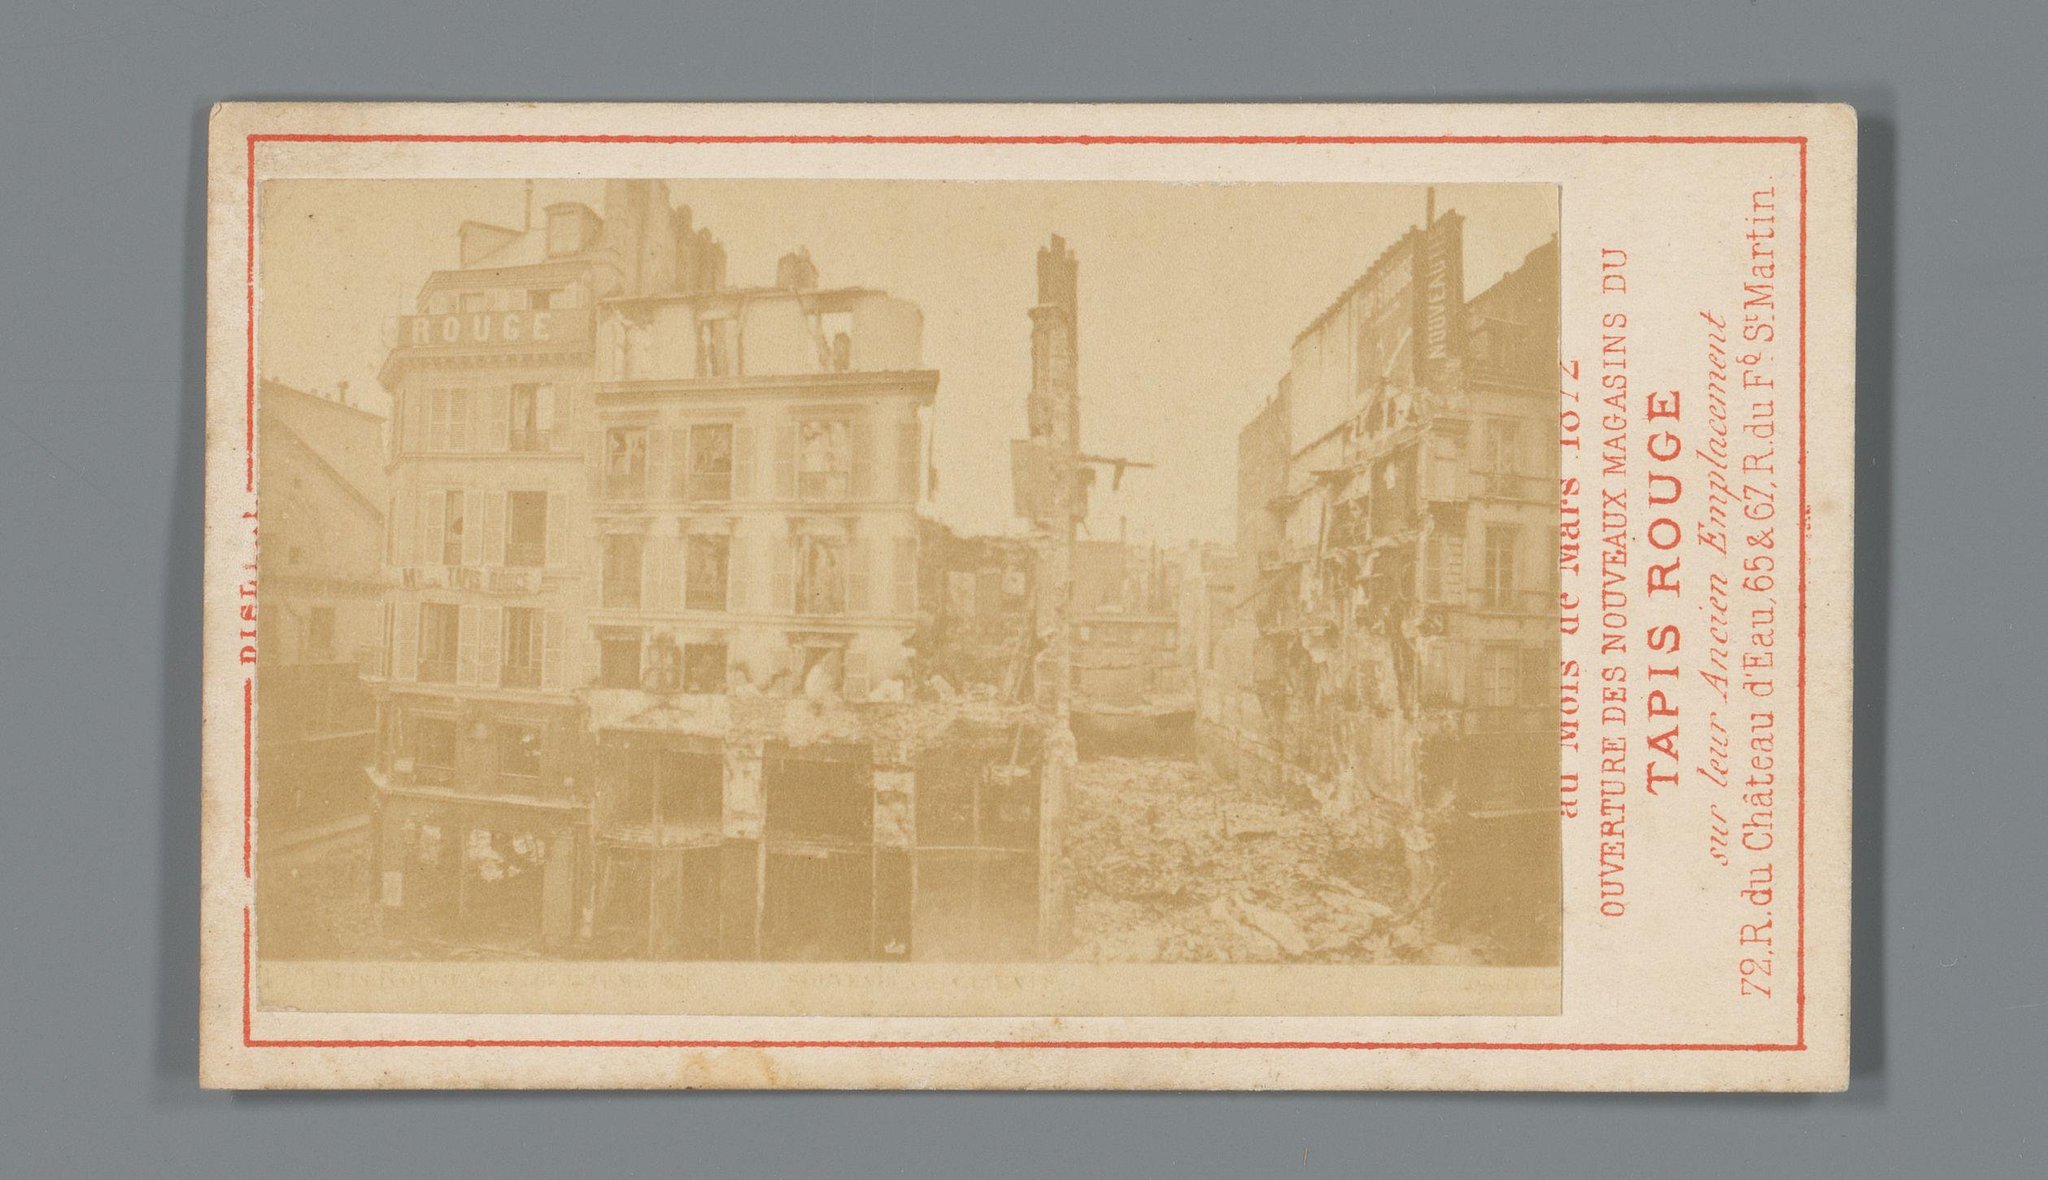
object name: photograph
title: Gezicht op gesloopte gebouwen op de plaats van warenhuis Tapis Rouge in Parijs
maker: Anonymous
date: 1872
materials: cardboard, photographic support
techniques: albumen print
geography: paris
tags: advertising, ruin of a building ~ architecture, edifice, e.g.: public building, department store, paris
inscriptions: inscription: ‘DISL[...]/au mois de Mars 1872/ OUVERTURE DES NOUVEAUX MAGASINS DU/ TAPIS ROUGE/ sur leur Ancien Emplacement/ 72.R.du Château d'Eau, 65&67R.du Fb St. Martin’, inscription: ‘Ao1281’